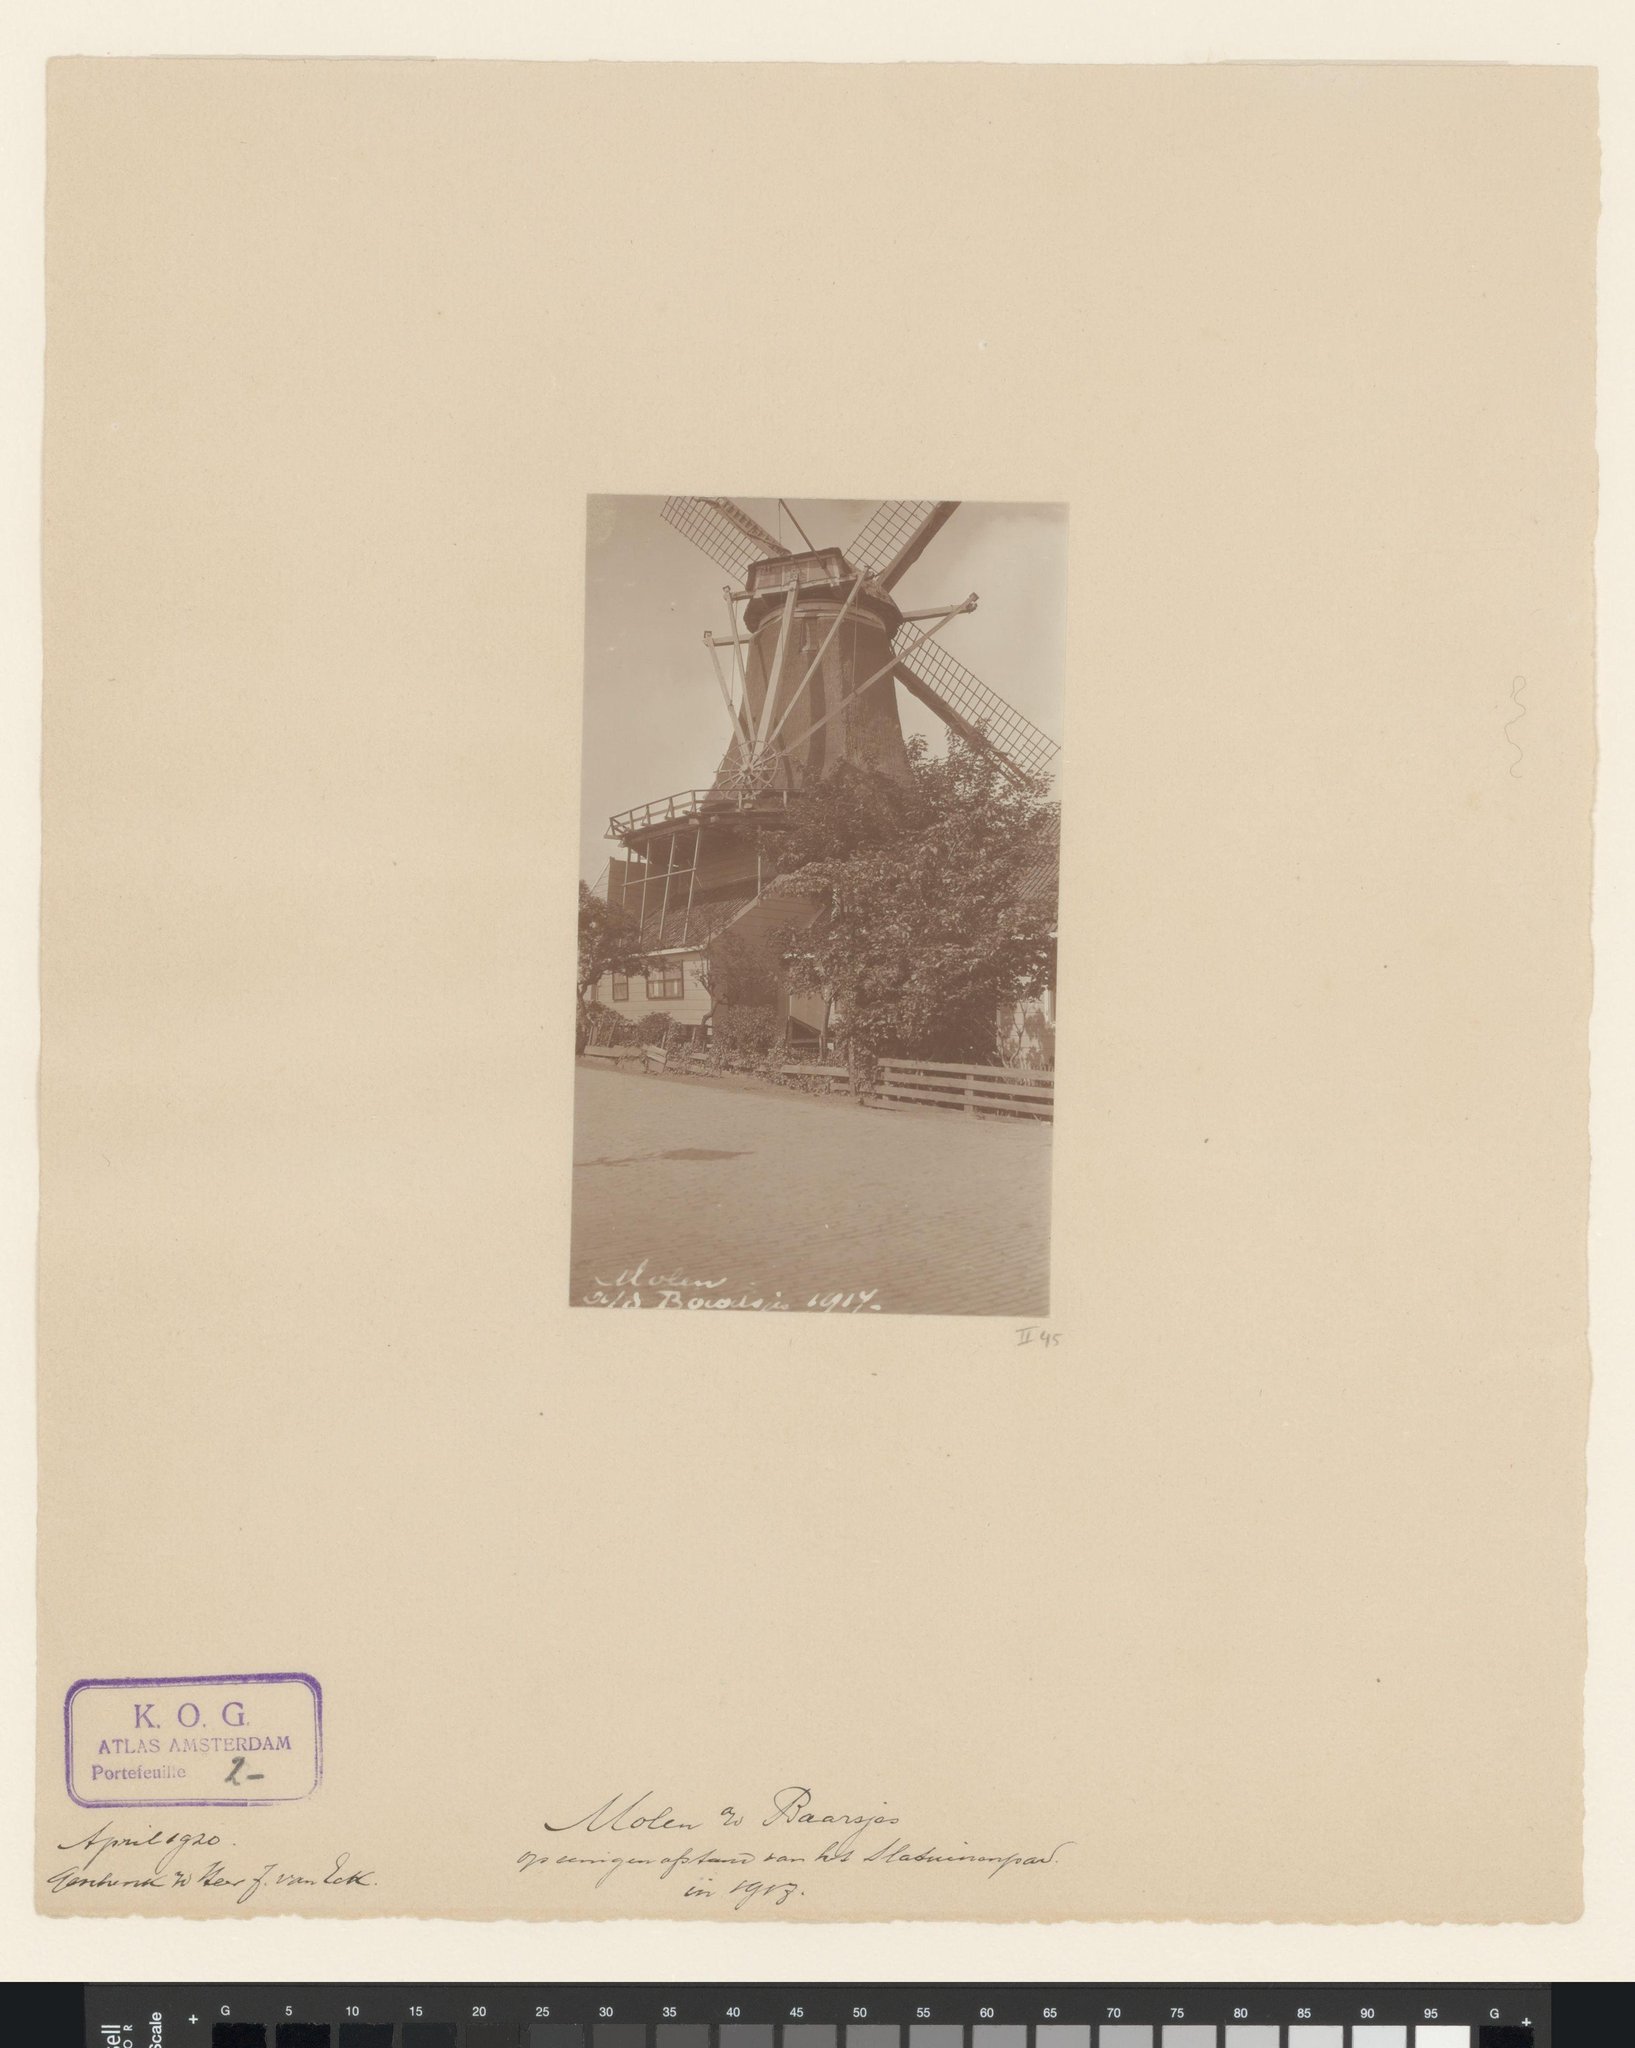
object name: photograph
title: Gezicht op de molen bij de Baarsjes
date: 1917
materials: cardboard, paper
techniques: albumen print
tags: city-view in general; 'veduta', windmill in landscape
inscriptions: inscription: ‘Molen / a/d Baarsjes 1917.’, collector's mark: ‘2-’ Lugt 1641b, inscription: ‘April 1920 / Geschenk v/d Heer J. van Eck. / Molen a/d Baarsjes / op eenigen afstand van het Slatuinenpad. / in 1917.’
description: Onderwerpsrubriek binnen de Atlas Amsterdam: Kostverloren Wetering.